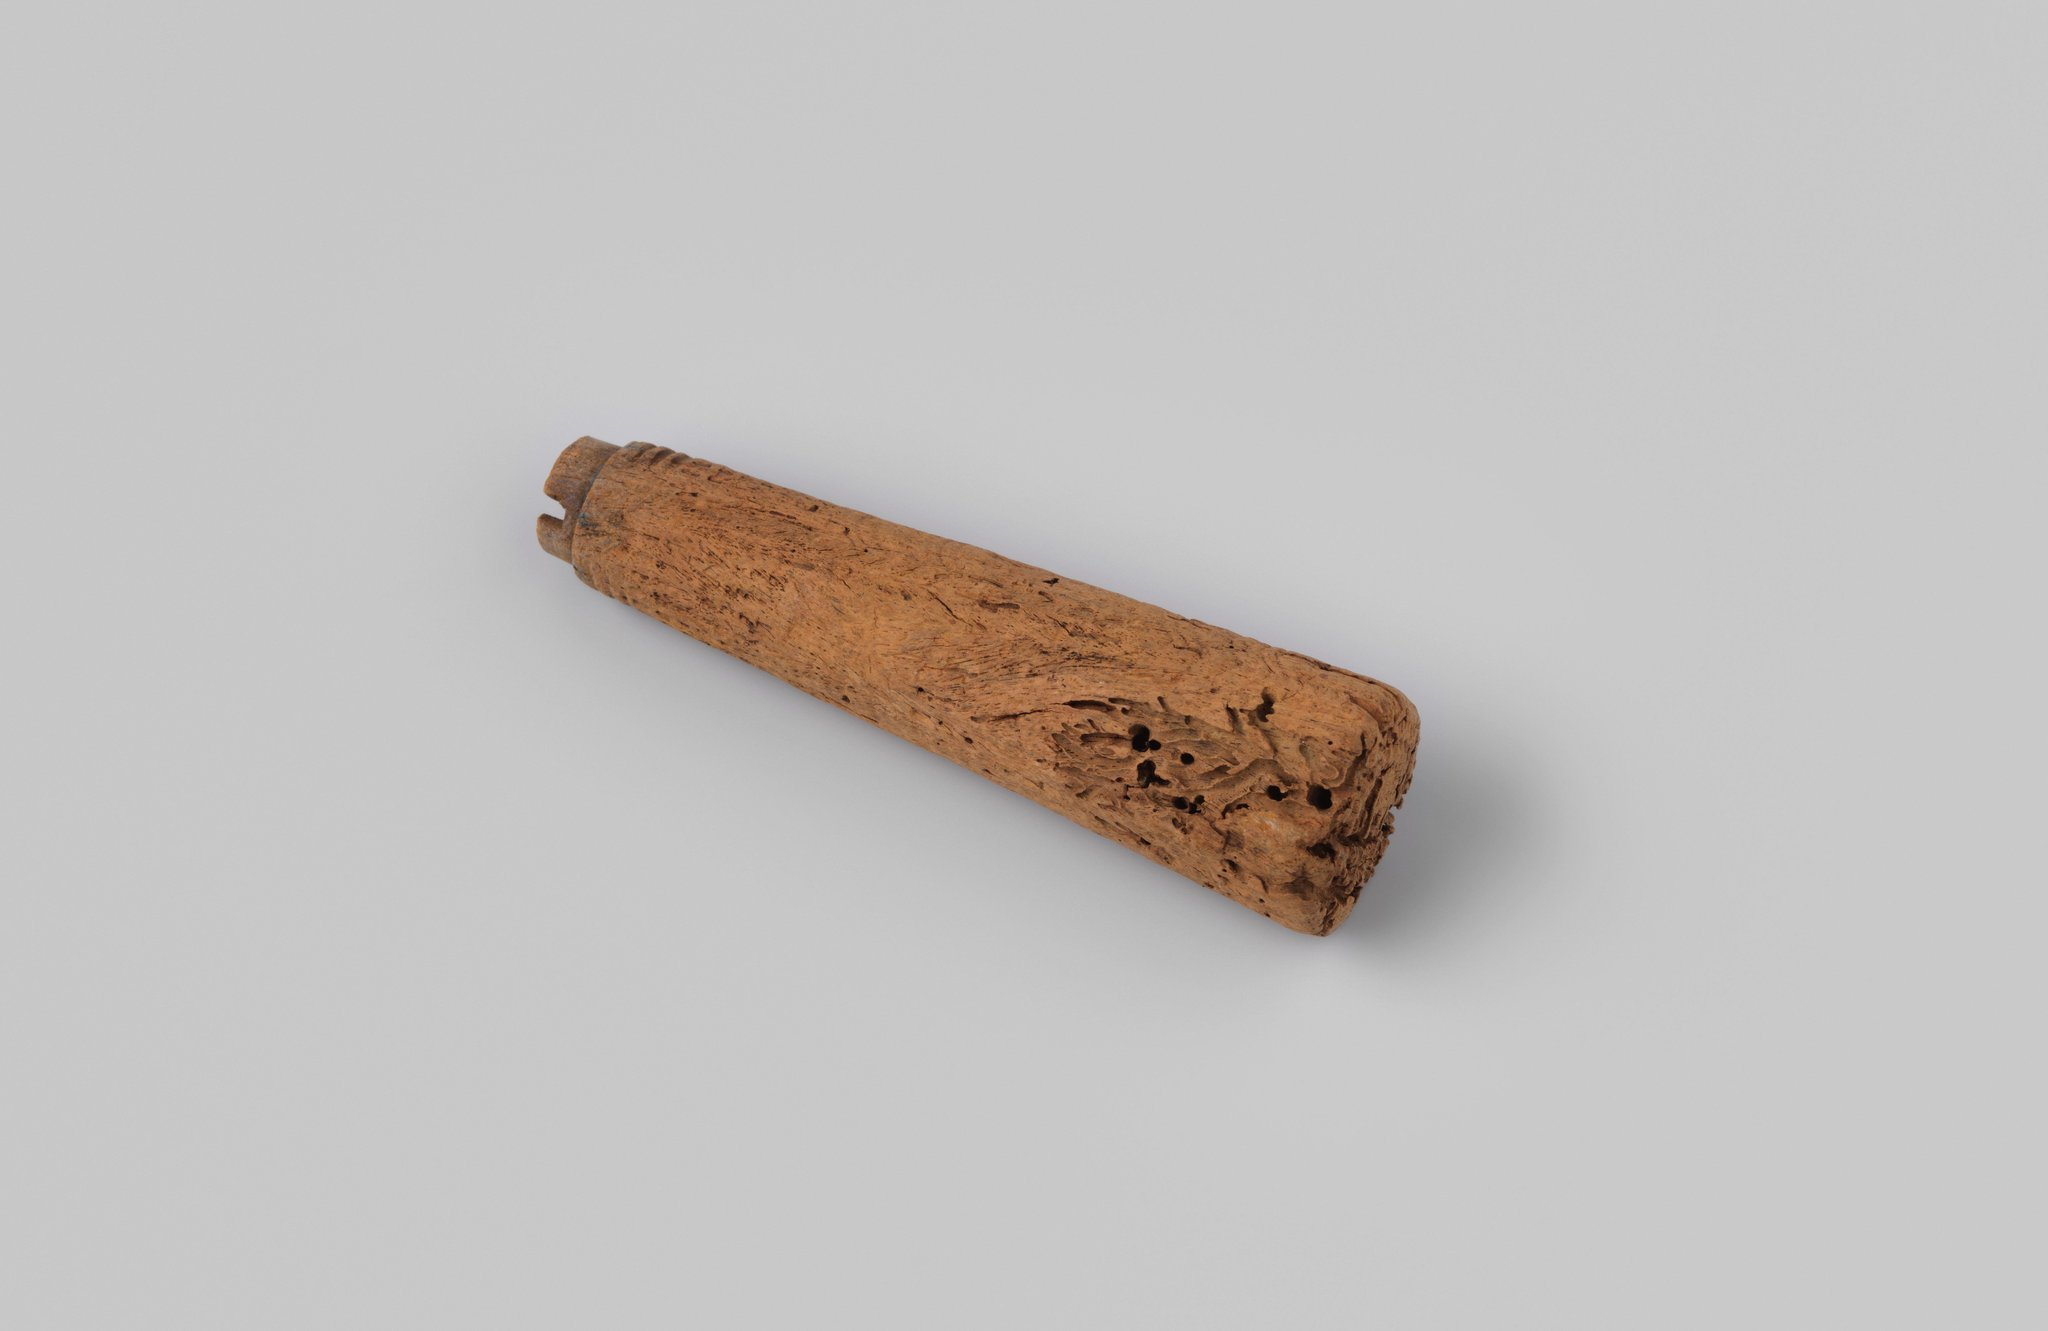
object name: knife handle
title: Messenheft uit het wrak van de Oost-Indiëvaarder Hollandia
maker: Anonymous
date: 1700-1743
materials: wood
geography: netherlands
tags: verenigde oostindische compagnie, hollandia (schip), annet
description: Knife, handle, cylindrical: tapering; id. NG 1979-403H, ferrules id. NG 1980-27H426.